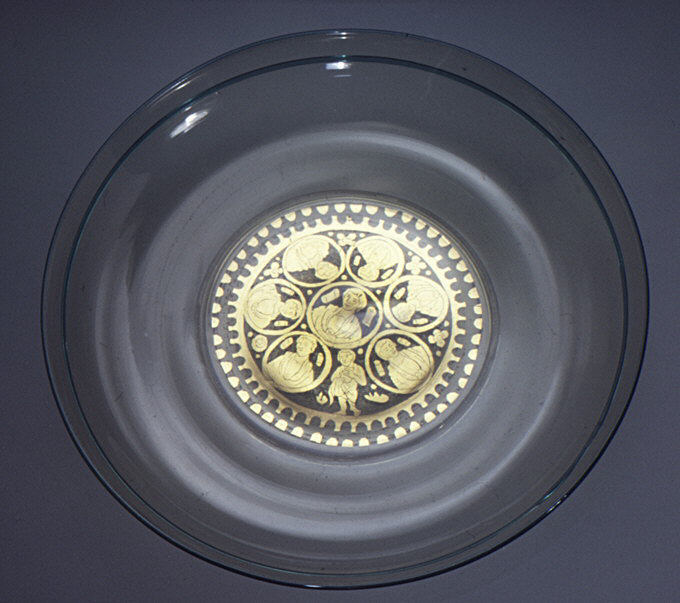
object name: plate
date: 1801-1900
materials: glass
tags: men